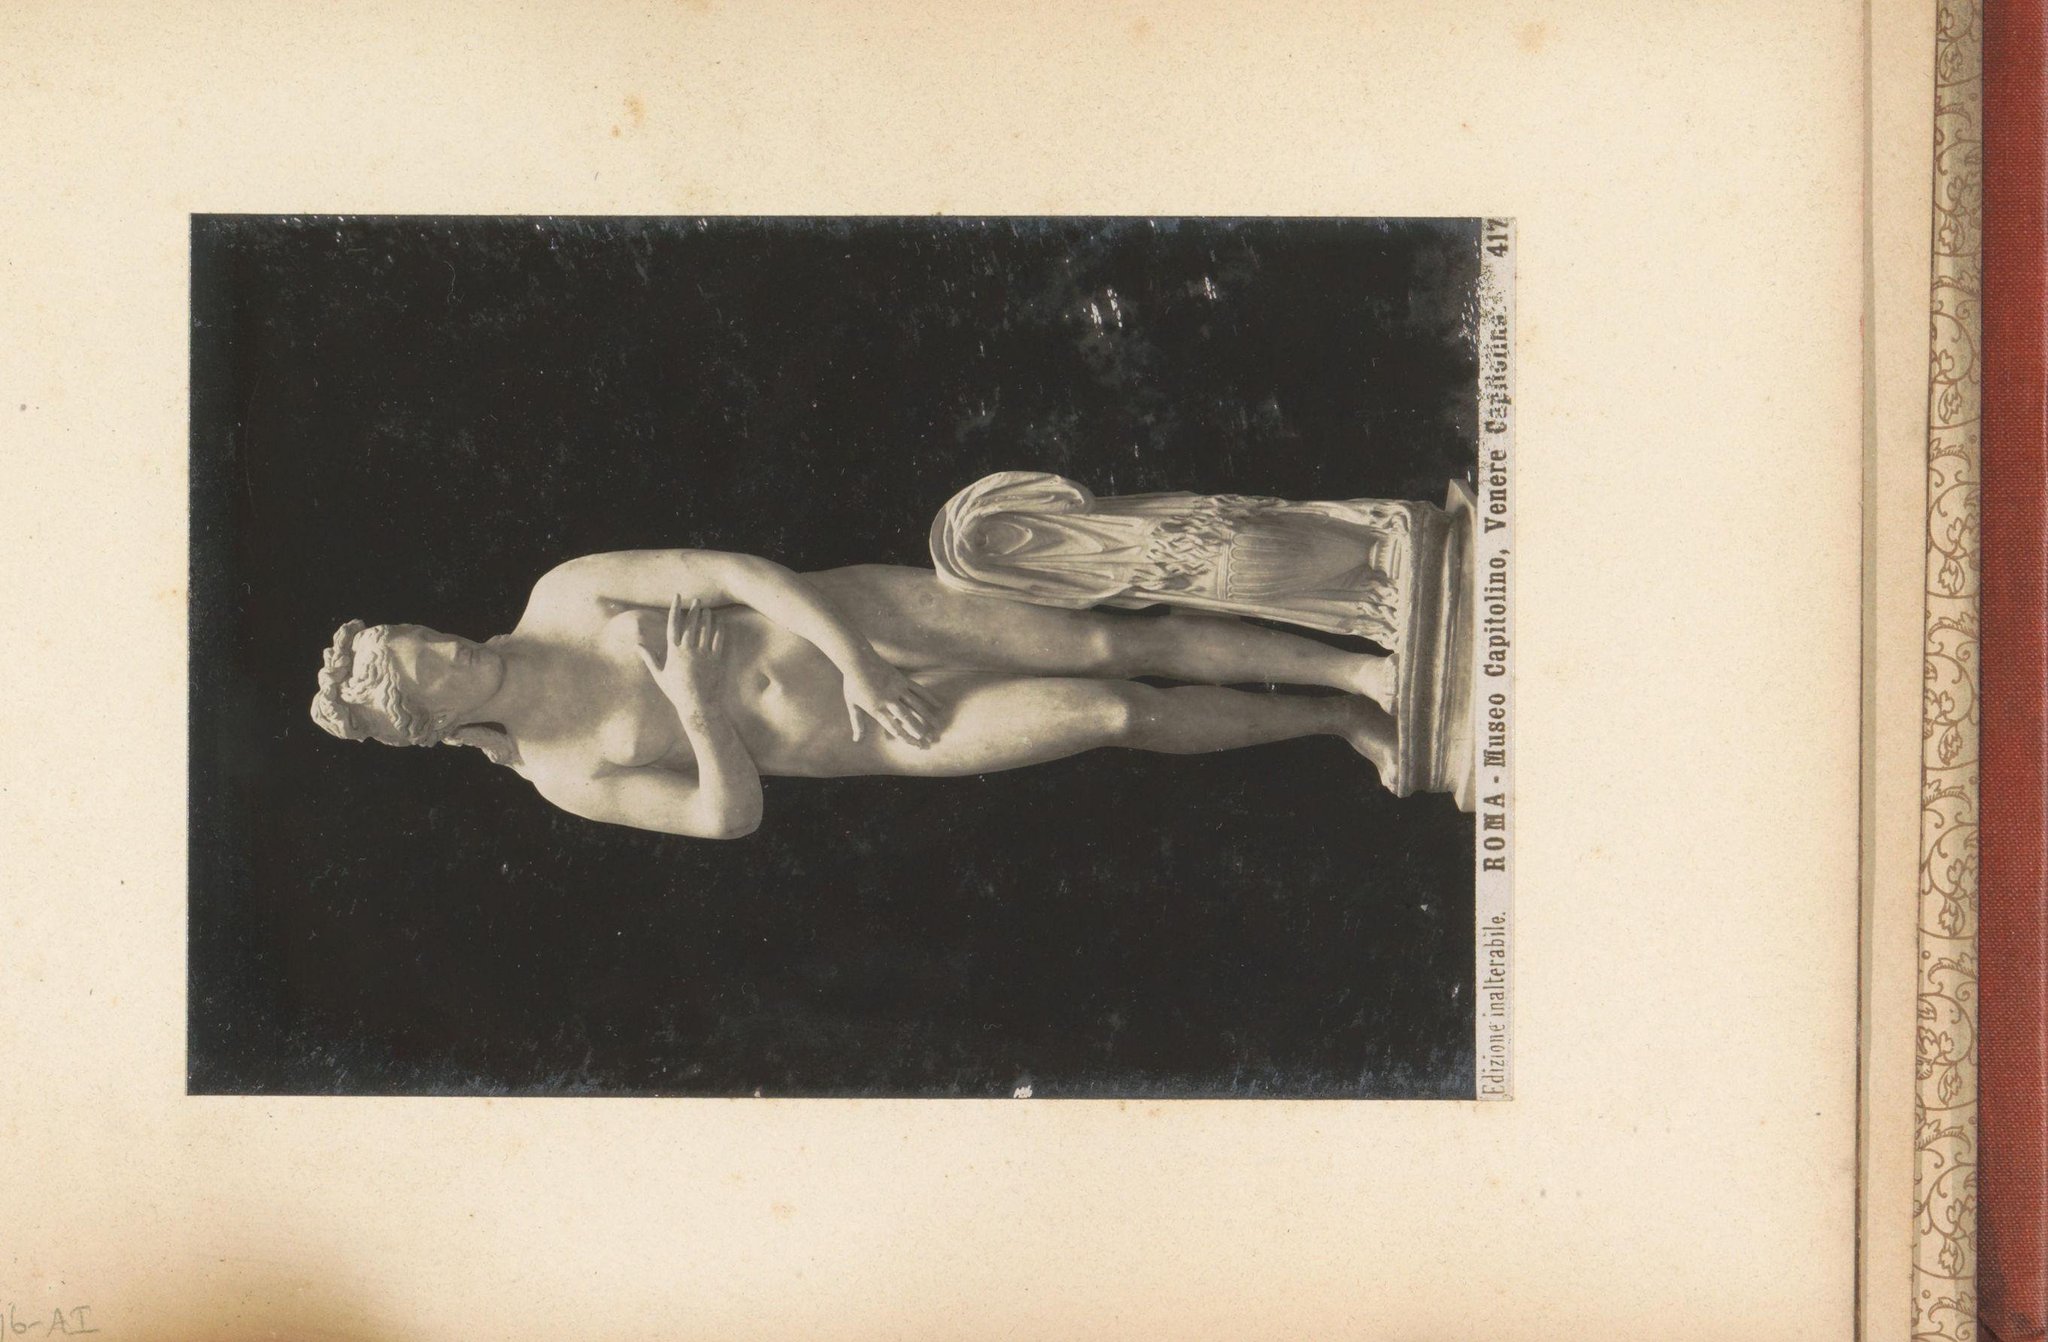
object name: photograph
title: ROMA - Museo Capitolino, Venere Capitolina.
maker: Anonymous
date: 1860-1890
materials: cardboard, photographic support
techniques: gelatin silver print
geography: rome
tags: piece of sculpture, reproduction of a piece of sculpture, permanent exhibition, museum, prospect of city, town panorama, silhouette of city, rome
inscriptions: number: ‘417’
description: Onderdeel van Fotoalbum met opnames van kerken, beelden en antieke gebouwen in Rome.